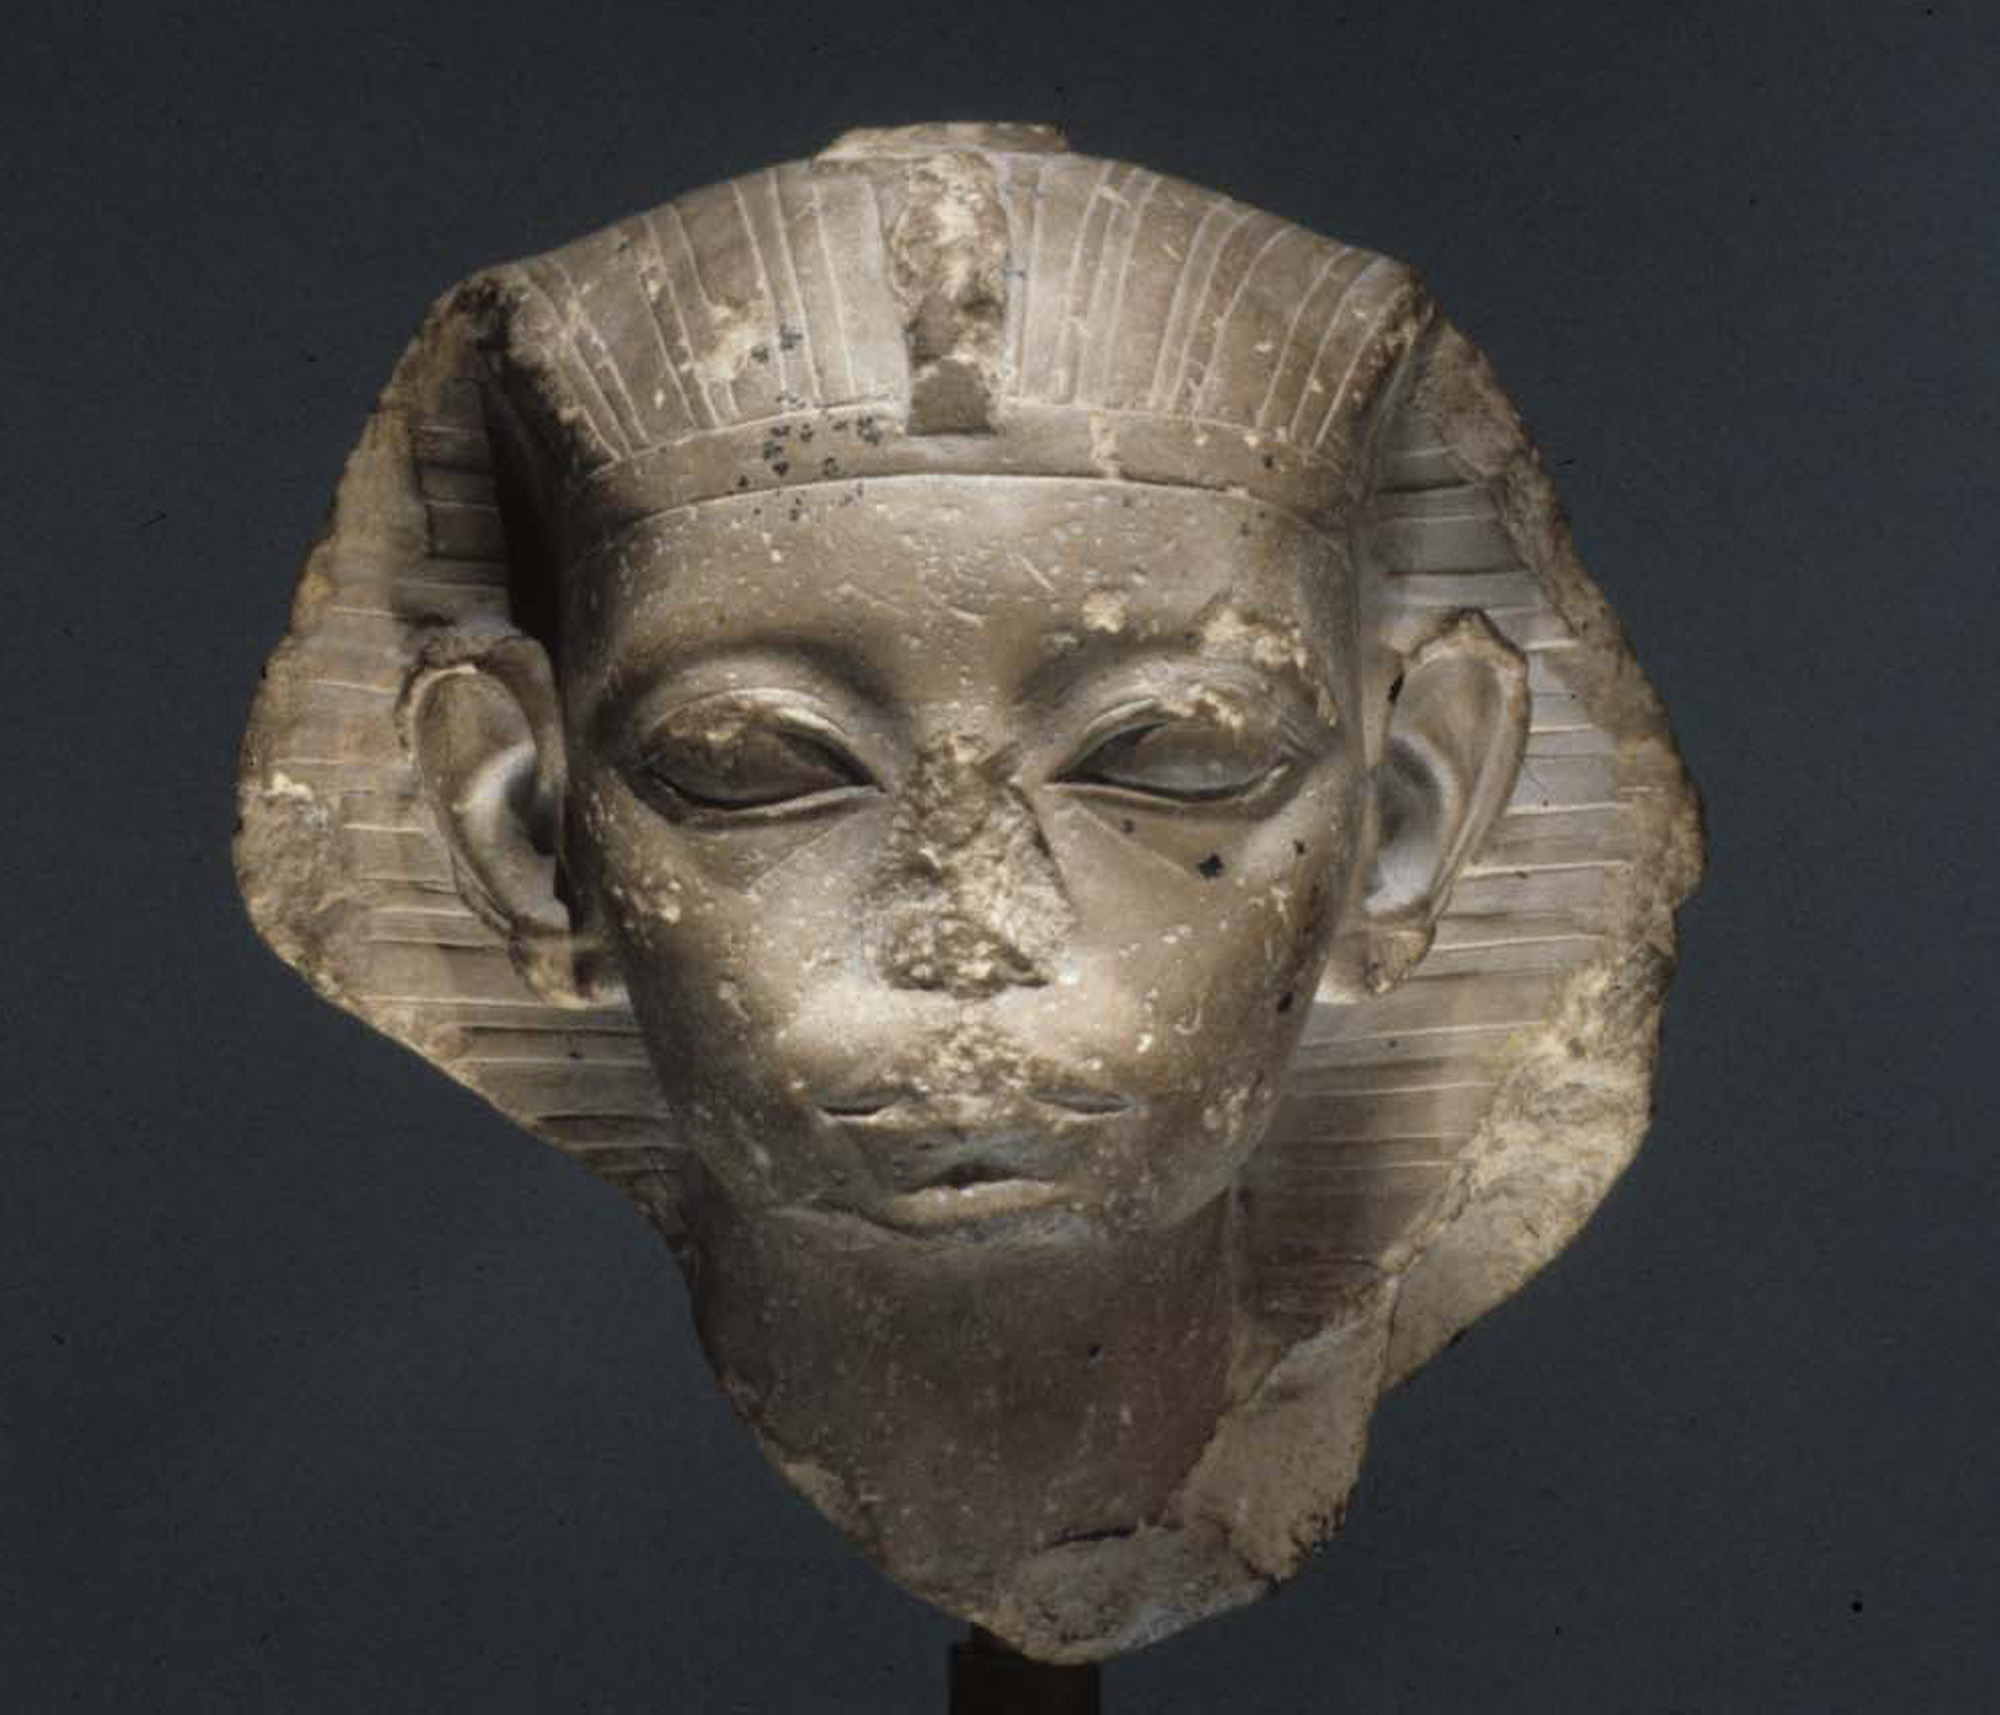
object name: head, amenemhat iv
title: Head of a King, possibly Amememhat IV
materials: limestone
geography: egypt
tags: kings,heads,mk-kings